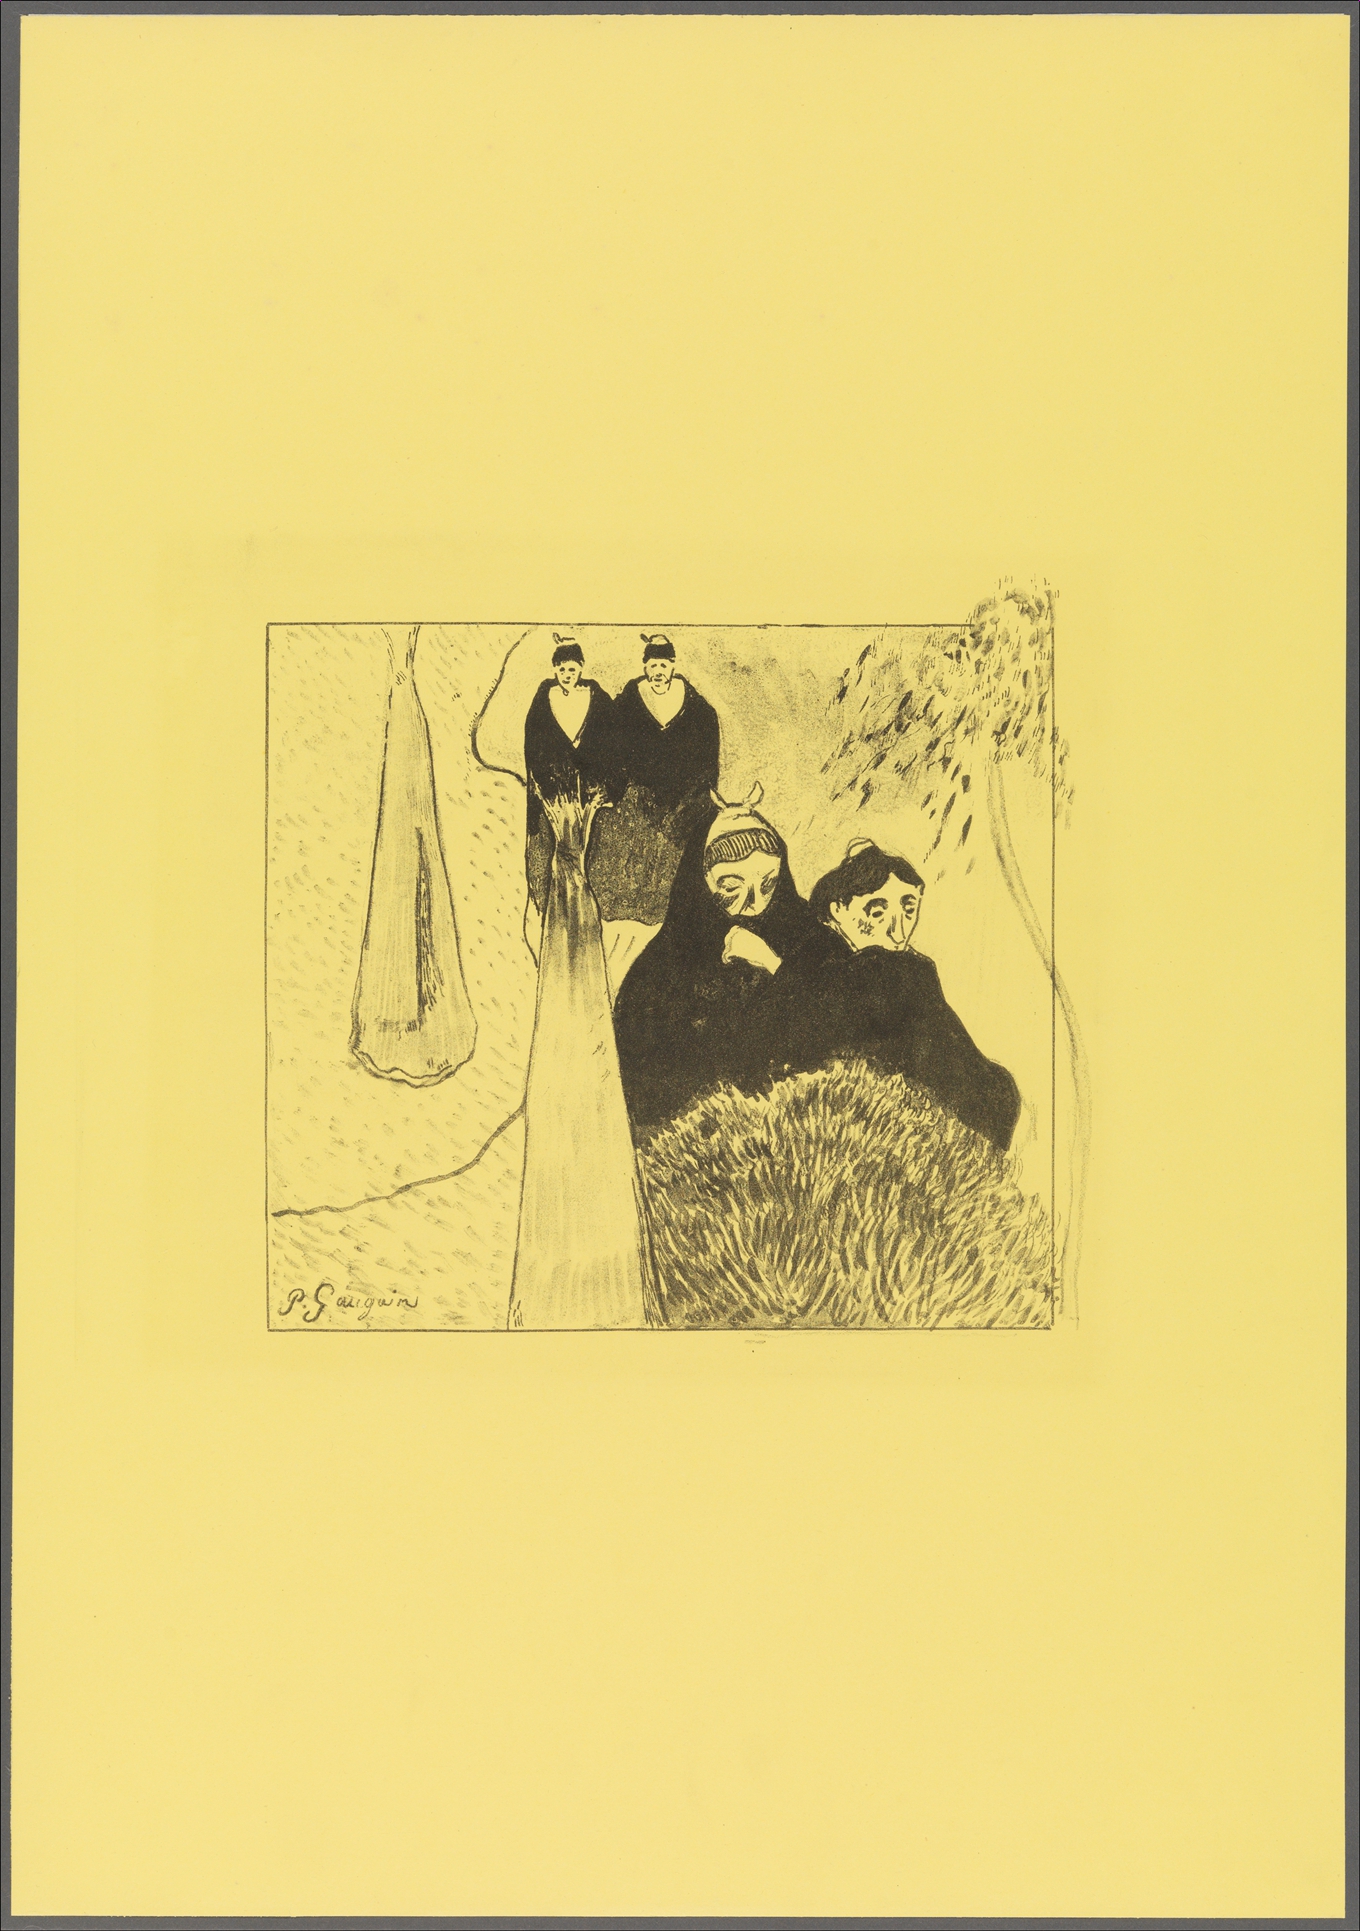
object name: print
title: Old Women of Arles, from the "Volpini Suite: Dessins lithographiques"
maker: paul gauguin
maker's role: artist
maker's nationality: french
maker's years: 1848-1903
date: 1889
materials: paper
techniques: lithography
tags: women